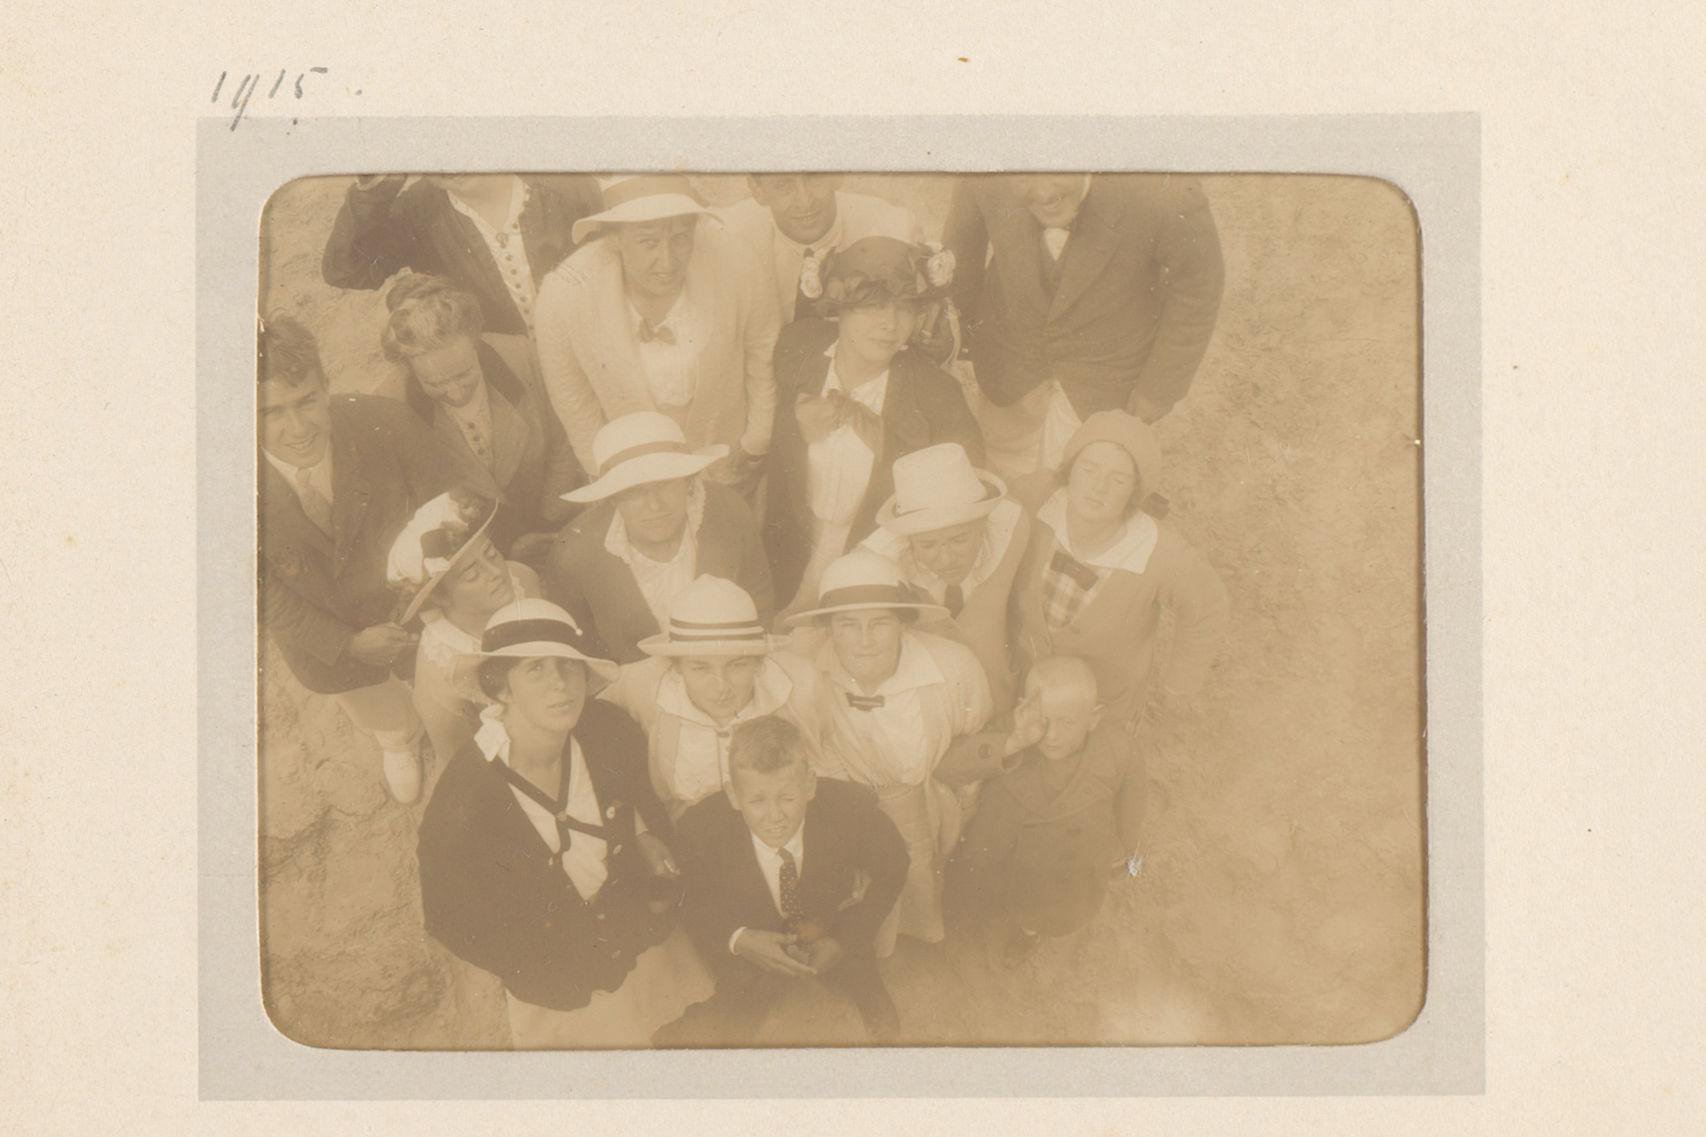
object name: photograph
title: Gezelschap kijkt naar boven, van bovenaf gezien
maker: liesbeth overhoff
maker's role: fotograaf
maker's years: 1895-1969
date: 1915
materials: paper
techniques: gelatin silver print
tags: historical persons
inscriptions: inscription: ‘1915’